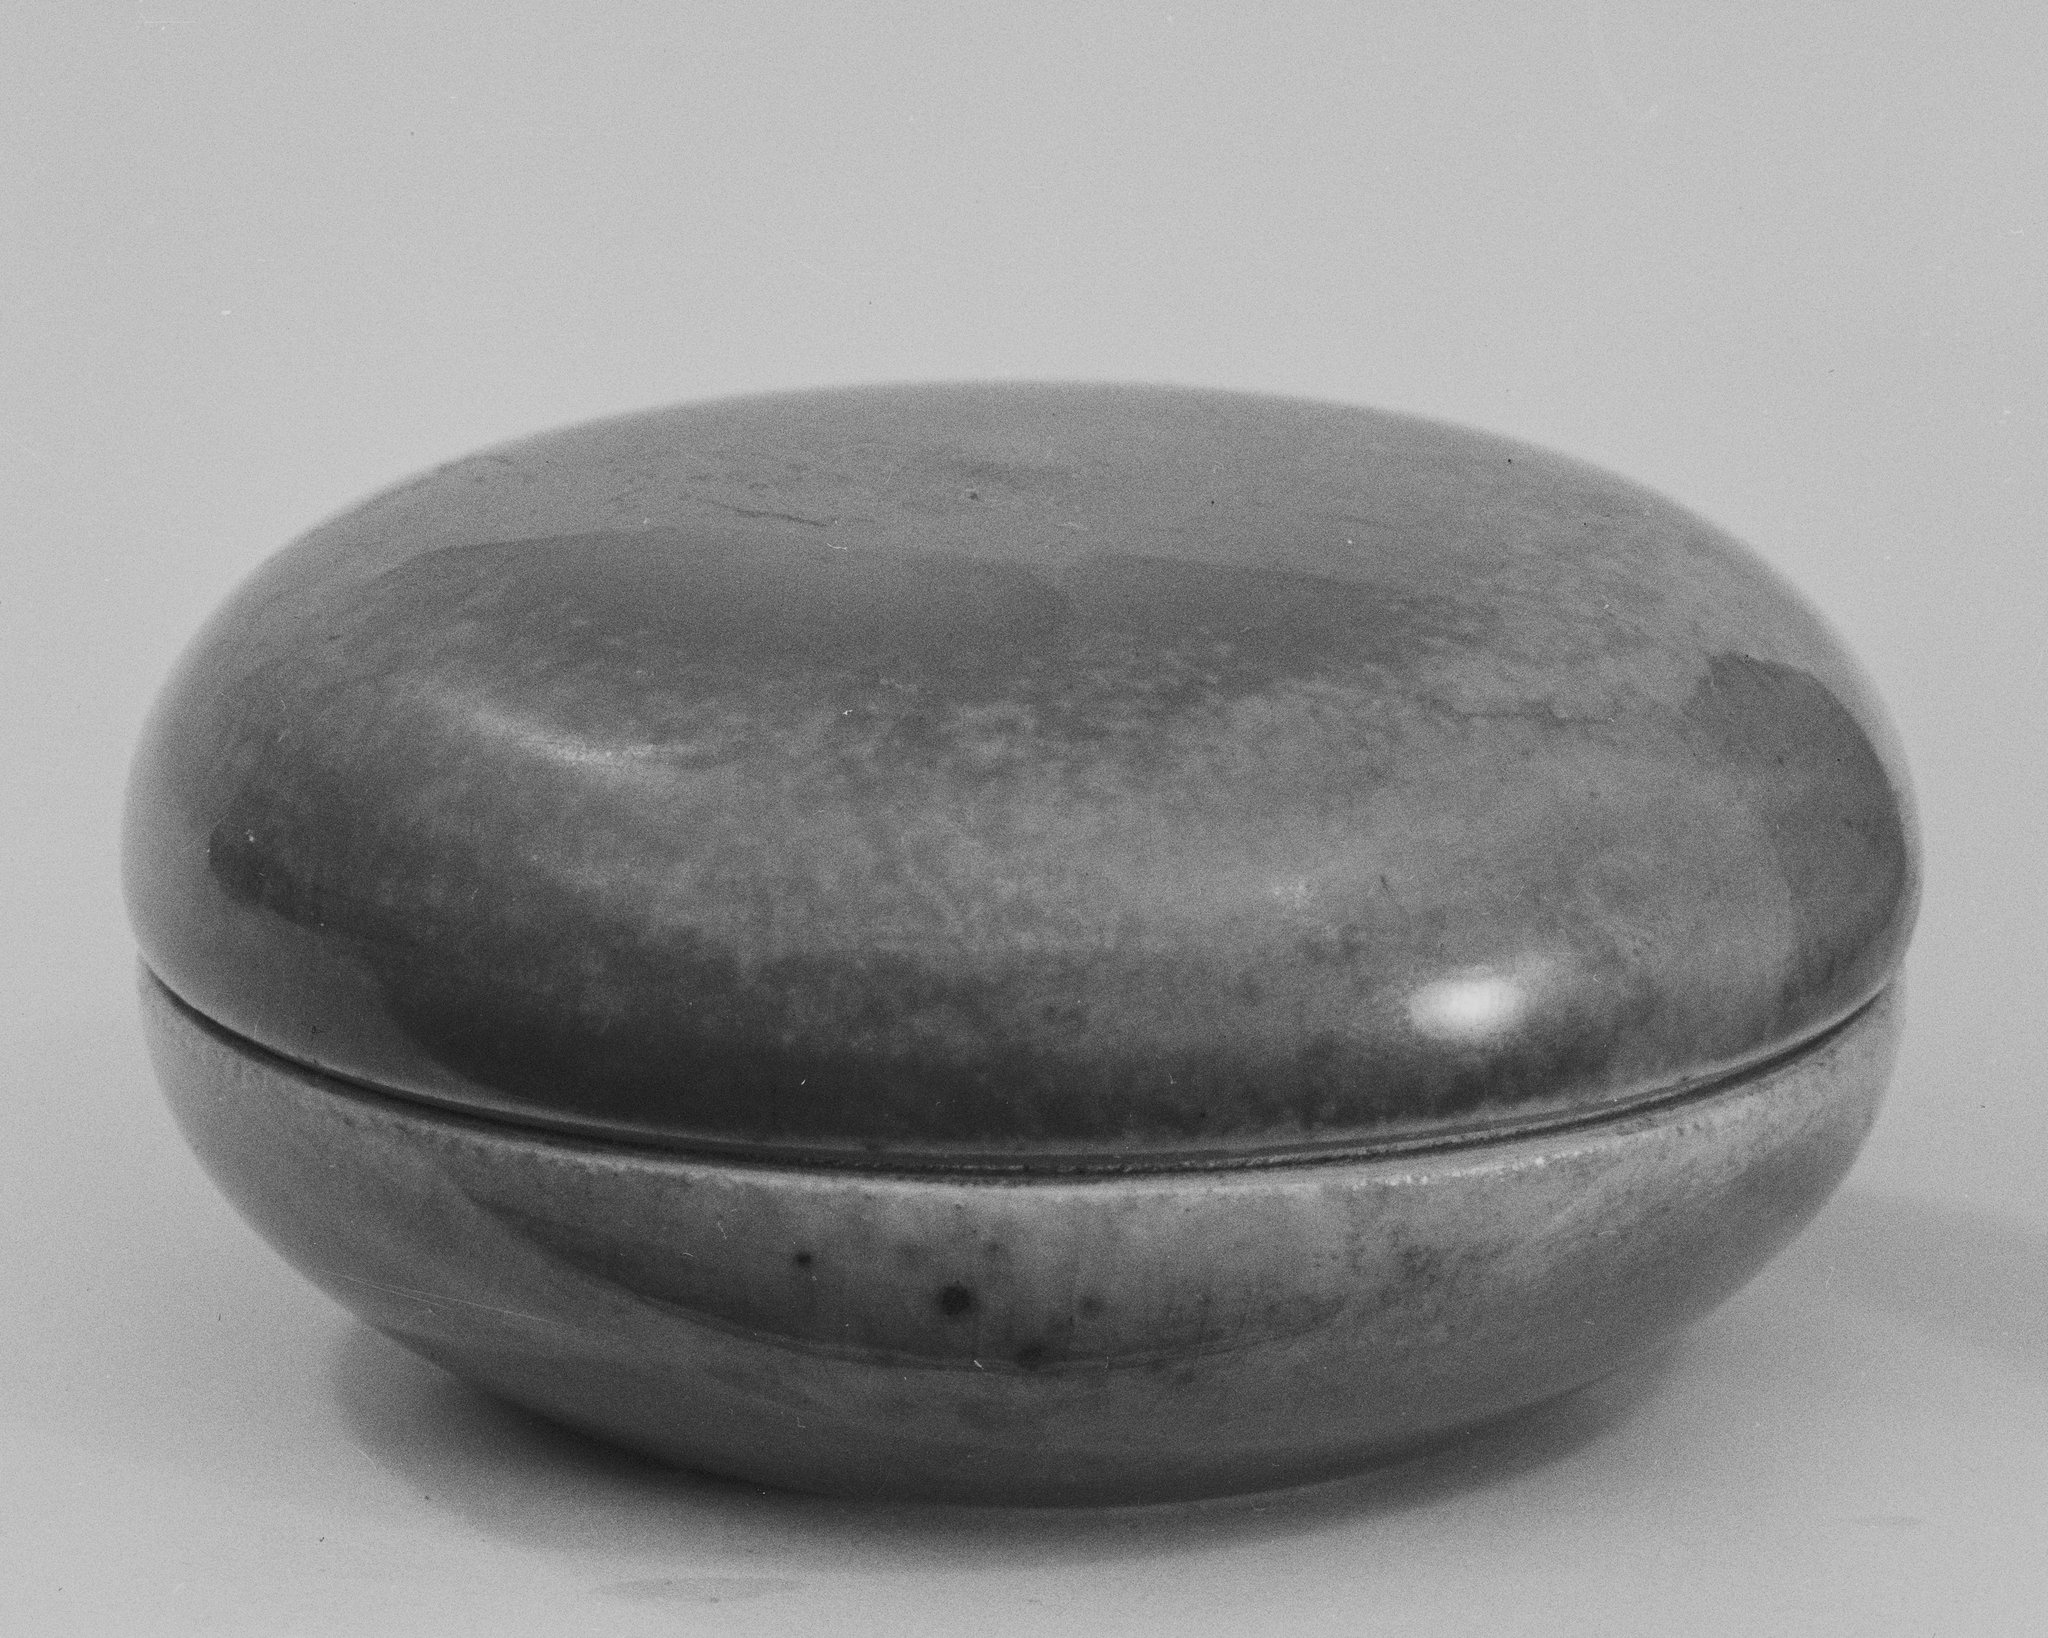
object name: covered box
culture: chinese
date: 1662-1722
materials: glaze, porcelain